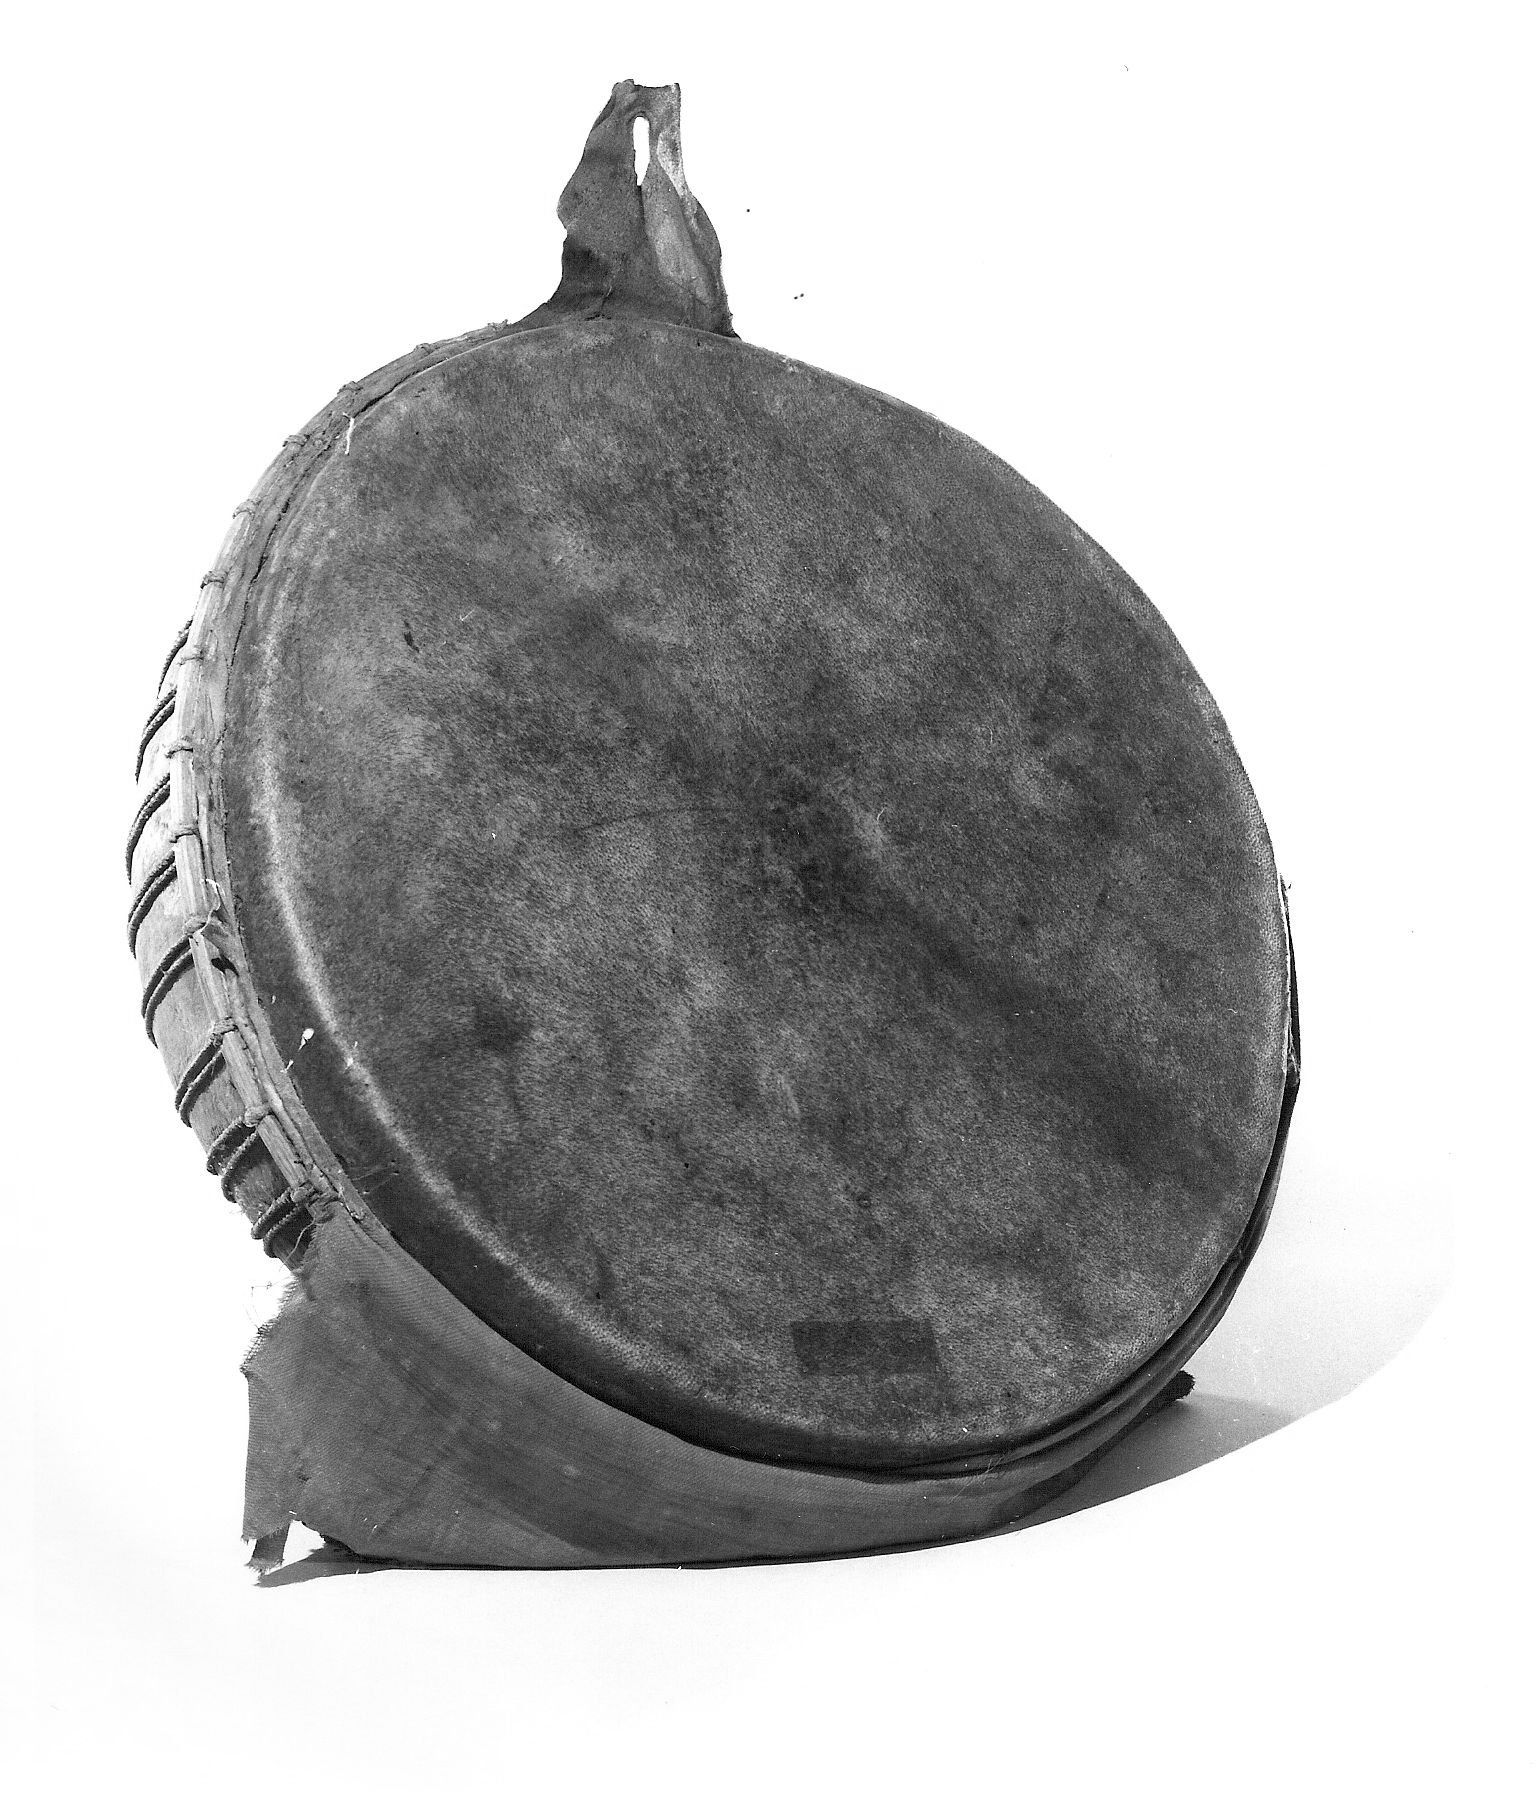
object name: drum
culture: malagasy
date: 1801-1900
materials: lace, skin, wood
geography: madagascar